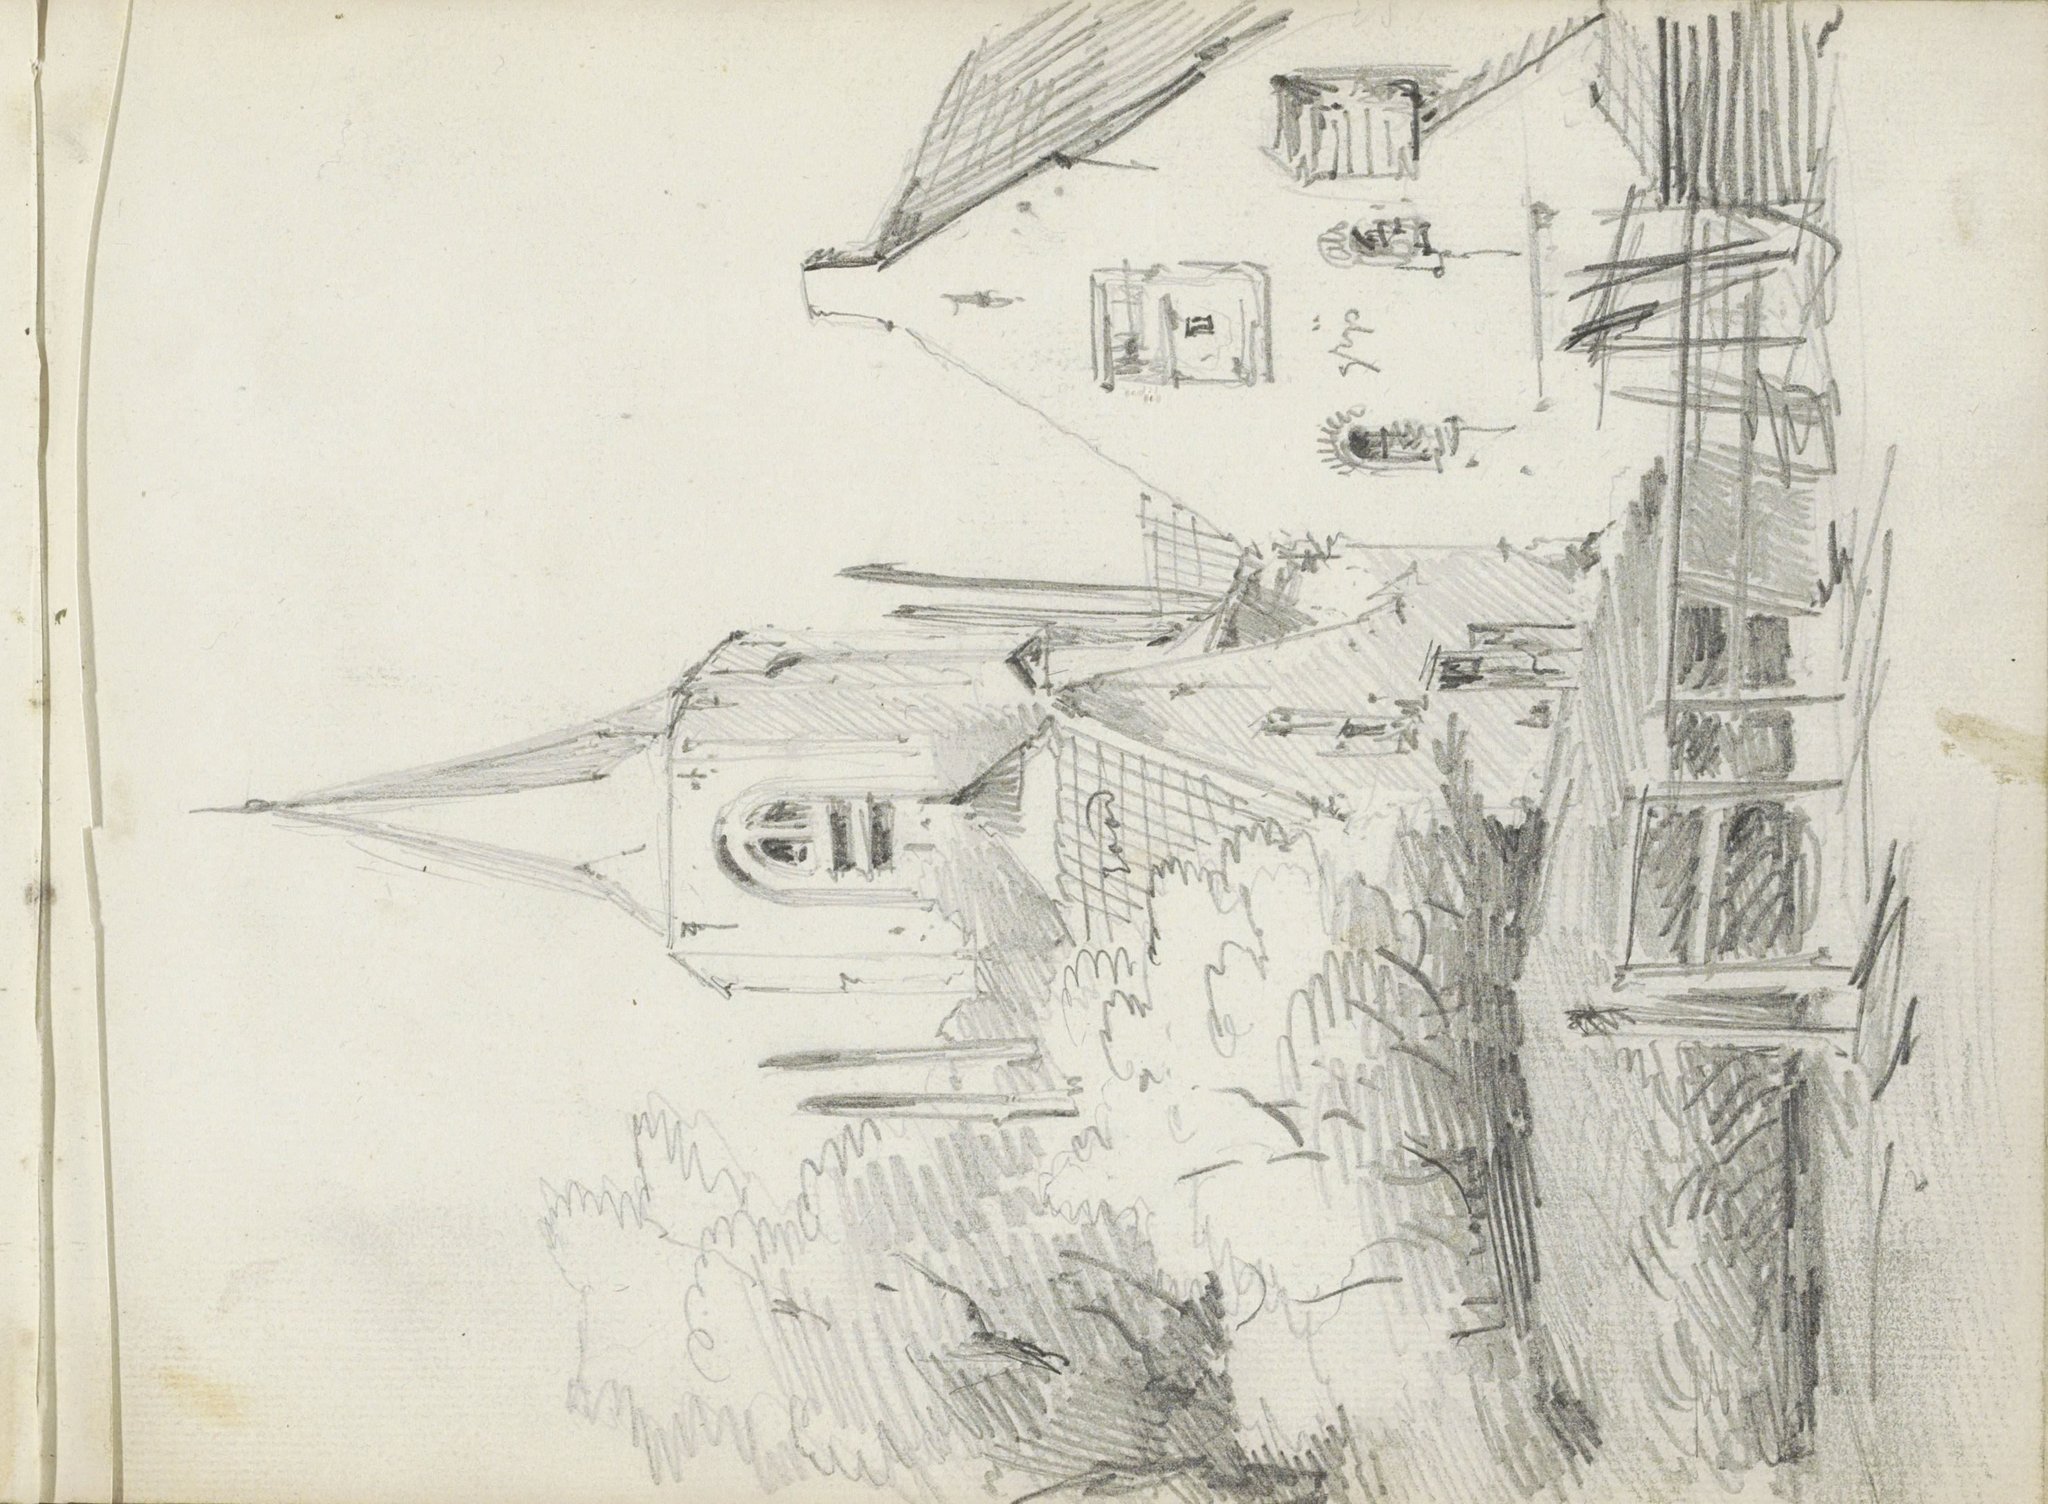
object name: sketchbook leaf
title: Dorpsgezicht met kerktoren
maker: willem koekkoek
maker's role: draughtsman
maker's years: 1839-1895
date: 1849-1895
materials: paper, pencil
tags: village, parts of church exterior and annexes: tower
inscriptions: kleurnotitie, handgeschreven in potlood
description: Pagina 8 recto uit een schetsboek met 26 bladen.